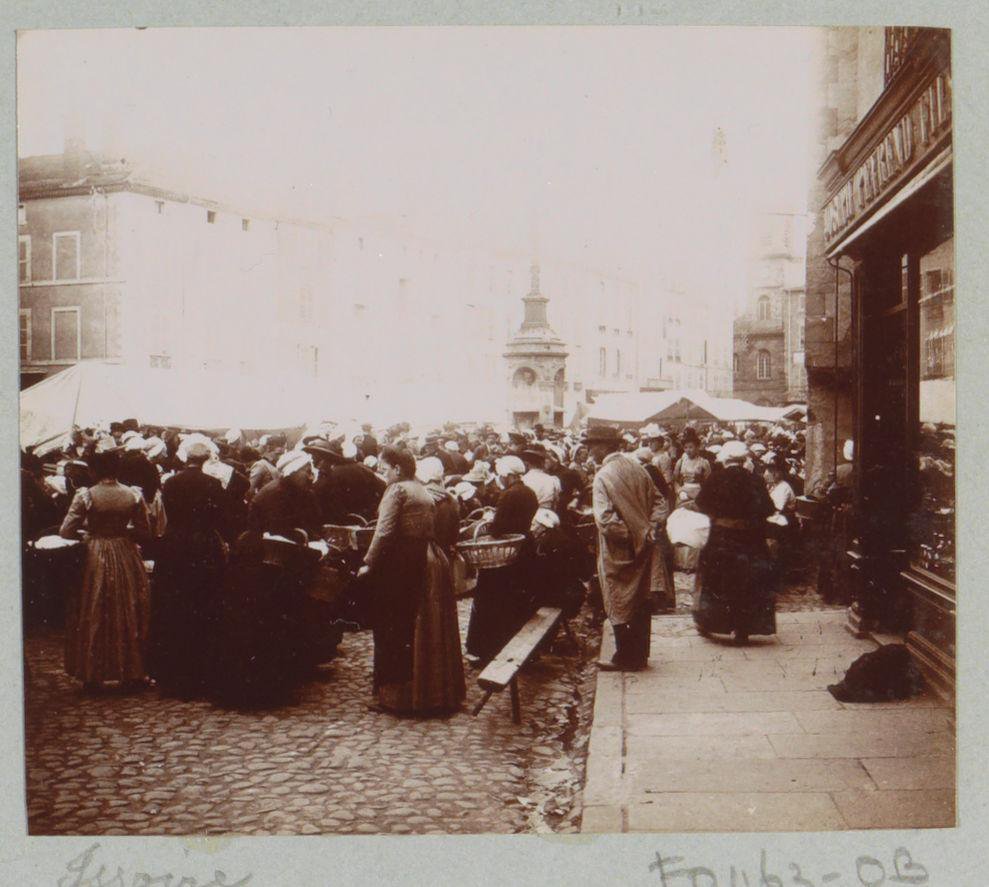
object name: photograph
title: Straatmarkt in Issoire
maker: delizy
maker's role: manufacturer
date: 1902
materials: paper, photographic support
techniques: gelatin silver print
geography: issoire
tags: market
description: Onderdeel van Fotoalbum van een Franse amateurfotograaf met opnames van uitstapjes in Frankrijk, Spanje, België, Luxemburg en Nederland, de eerste automobielen en autoraces.